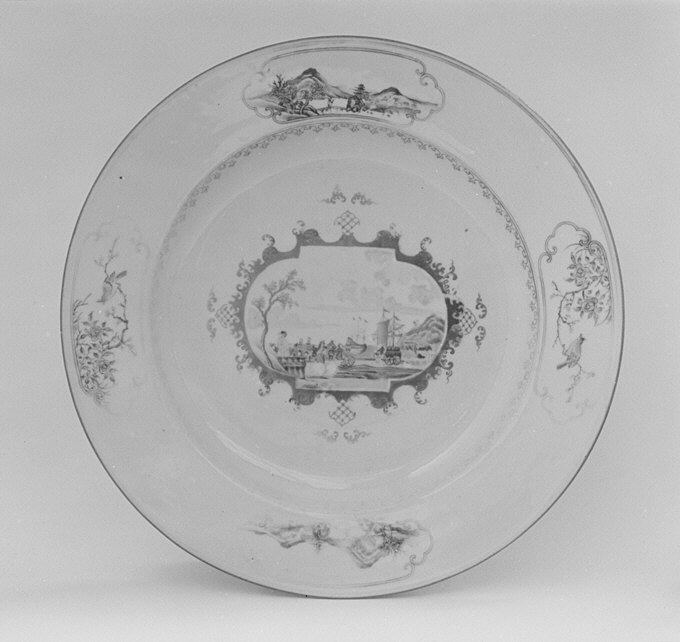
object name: platter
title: Platter (part of a service)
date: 1750-1760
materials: hard paste porcelain